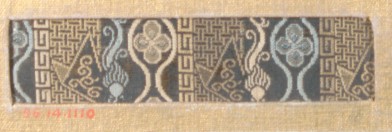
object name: piece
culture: japanese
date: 1701-1900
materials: silk